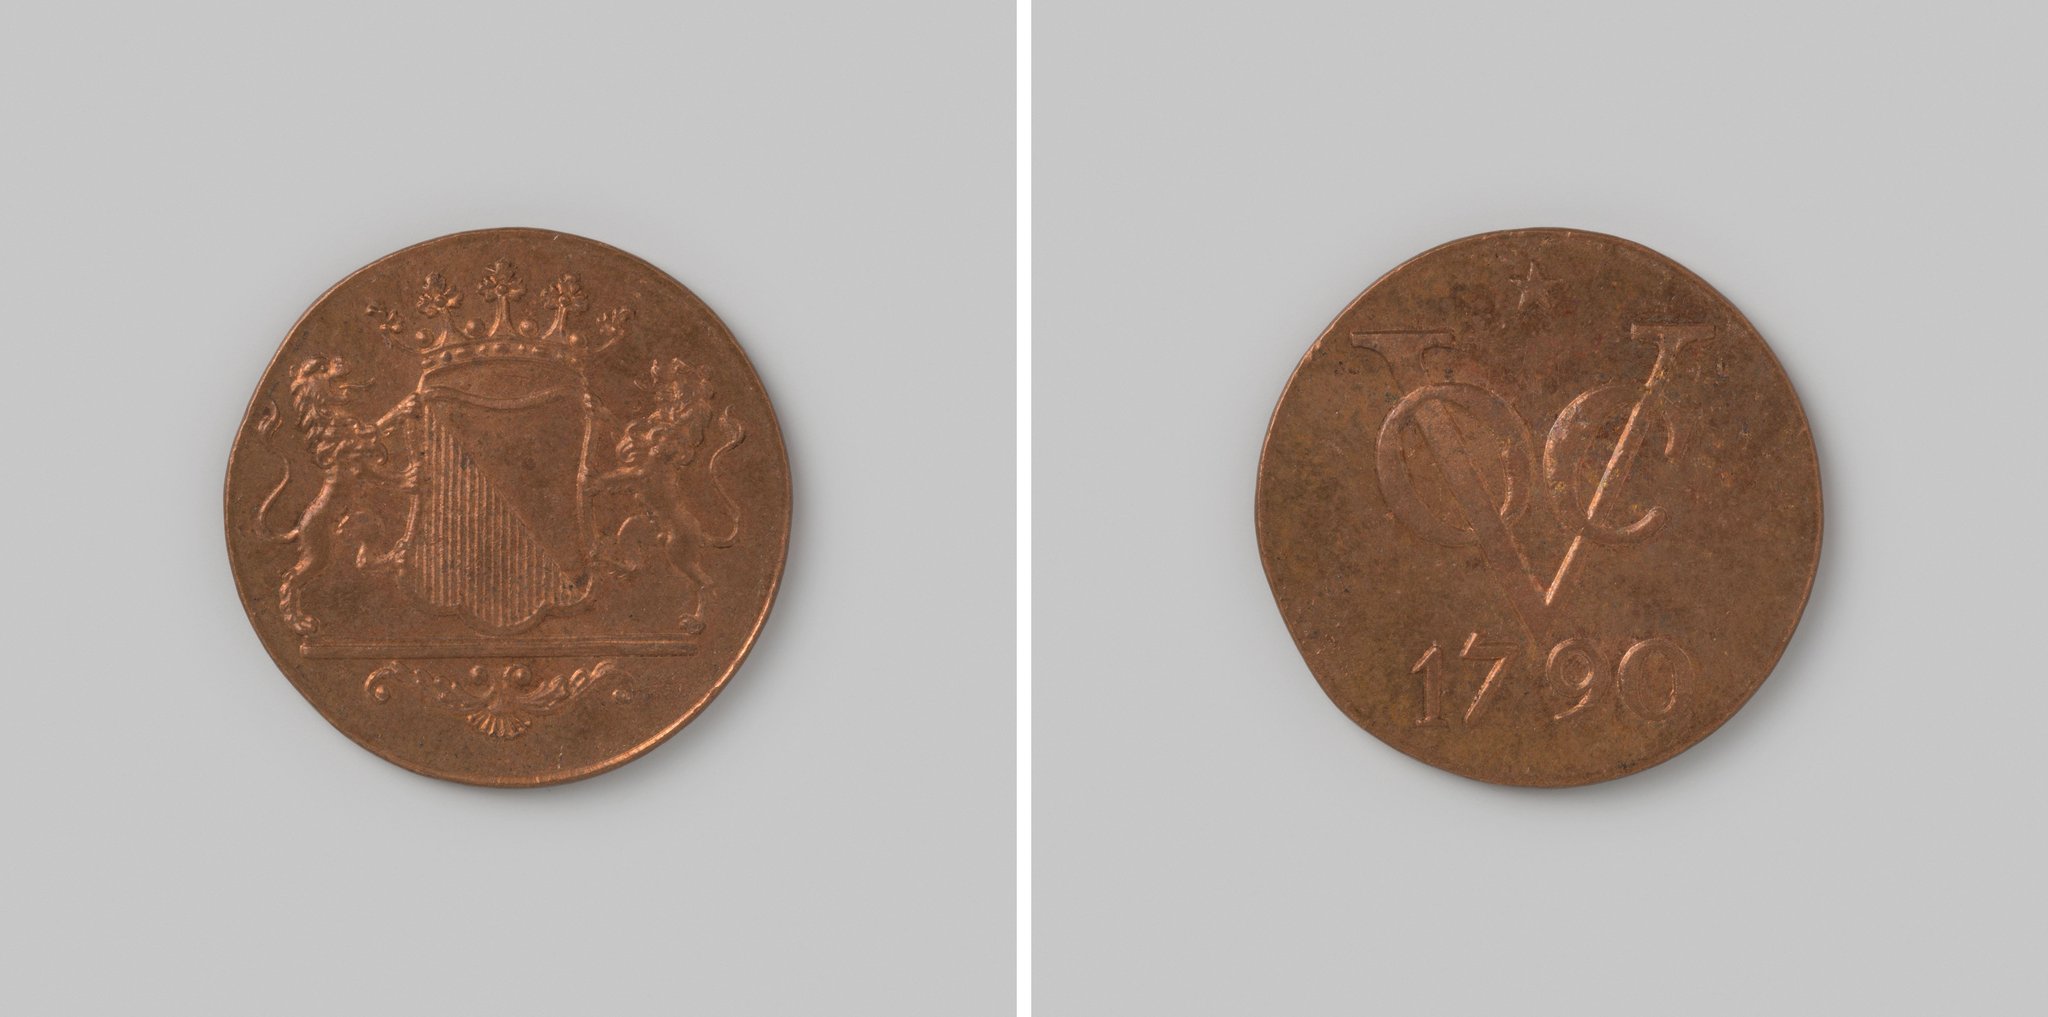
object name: coin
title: Dubbele duit op naam van de VOC en de stad Utrecht met jaartal1790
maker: william ii of the netherlands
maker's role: koning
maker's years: 1792-1849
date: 1840-1843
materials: copper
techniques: striking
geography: surabaya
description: Koperen munt. Voorzijde: op balk, waaronder guirlande, staand, door twee leeuwen gehouden gekroond wapenschild van de stad Utrecht. Keerzijde: monogram van de VOC, waarboven muntteken ster en waaronder fictief jaartal 1790. Gladde rand.